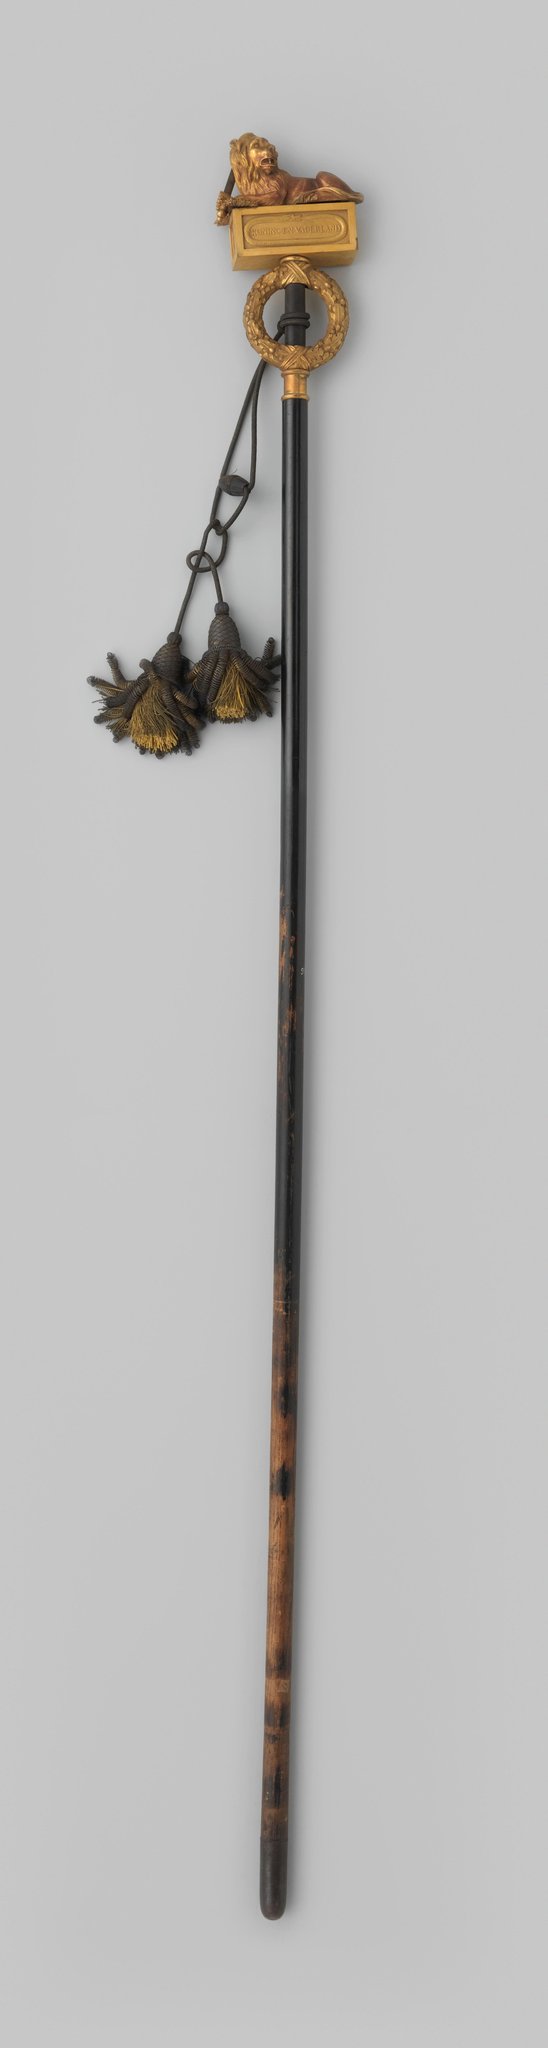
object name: standaard identificatiedrager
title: Stok van een standaard van het vijfde regiment dragonders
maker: Anonymous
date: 1846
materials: bronze, galloon, iron, textile, wood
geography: netherlands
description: Stok van een standaard van zwart gelakt hout, waarop een verguld bronzen krans van eiketakken, en op de top een liggende leeuw met pijlenbundel en zwaard op een dito blok, waarop aan de lange kanten de tekst: KONING EN VADERLAND, omgeven door een slang, en op de korte kanten een gekroonde W